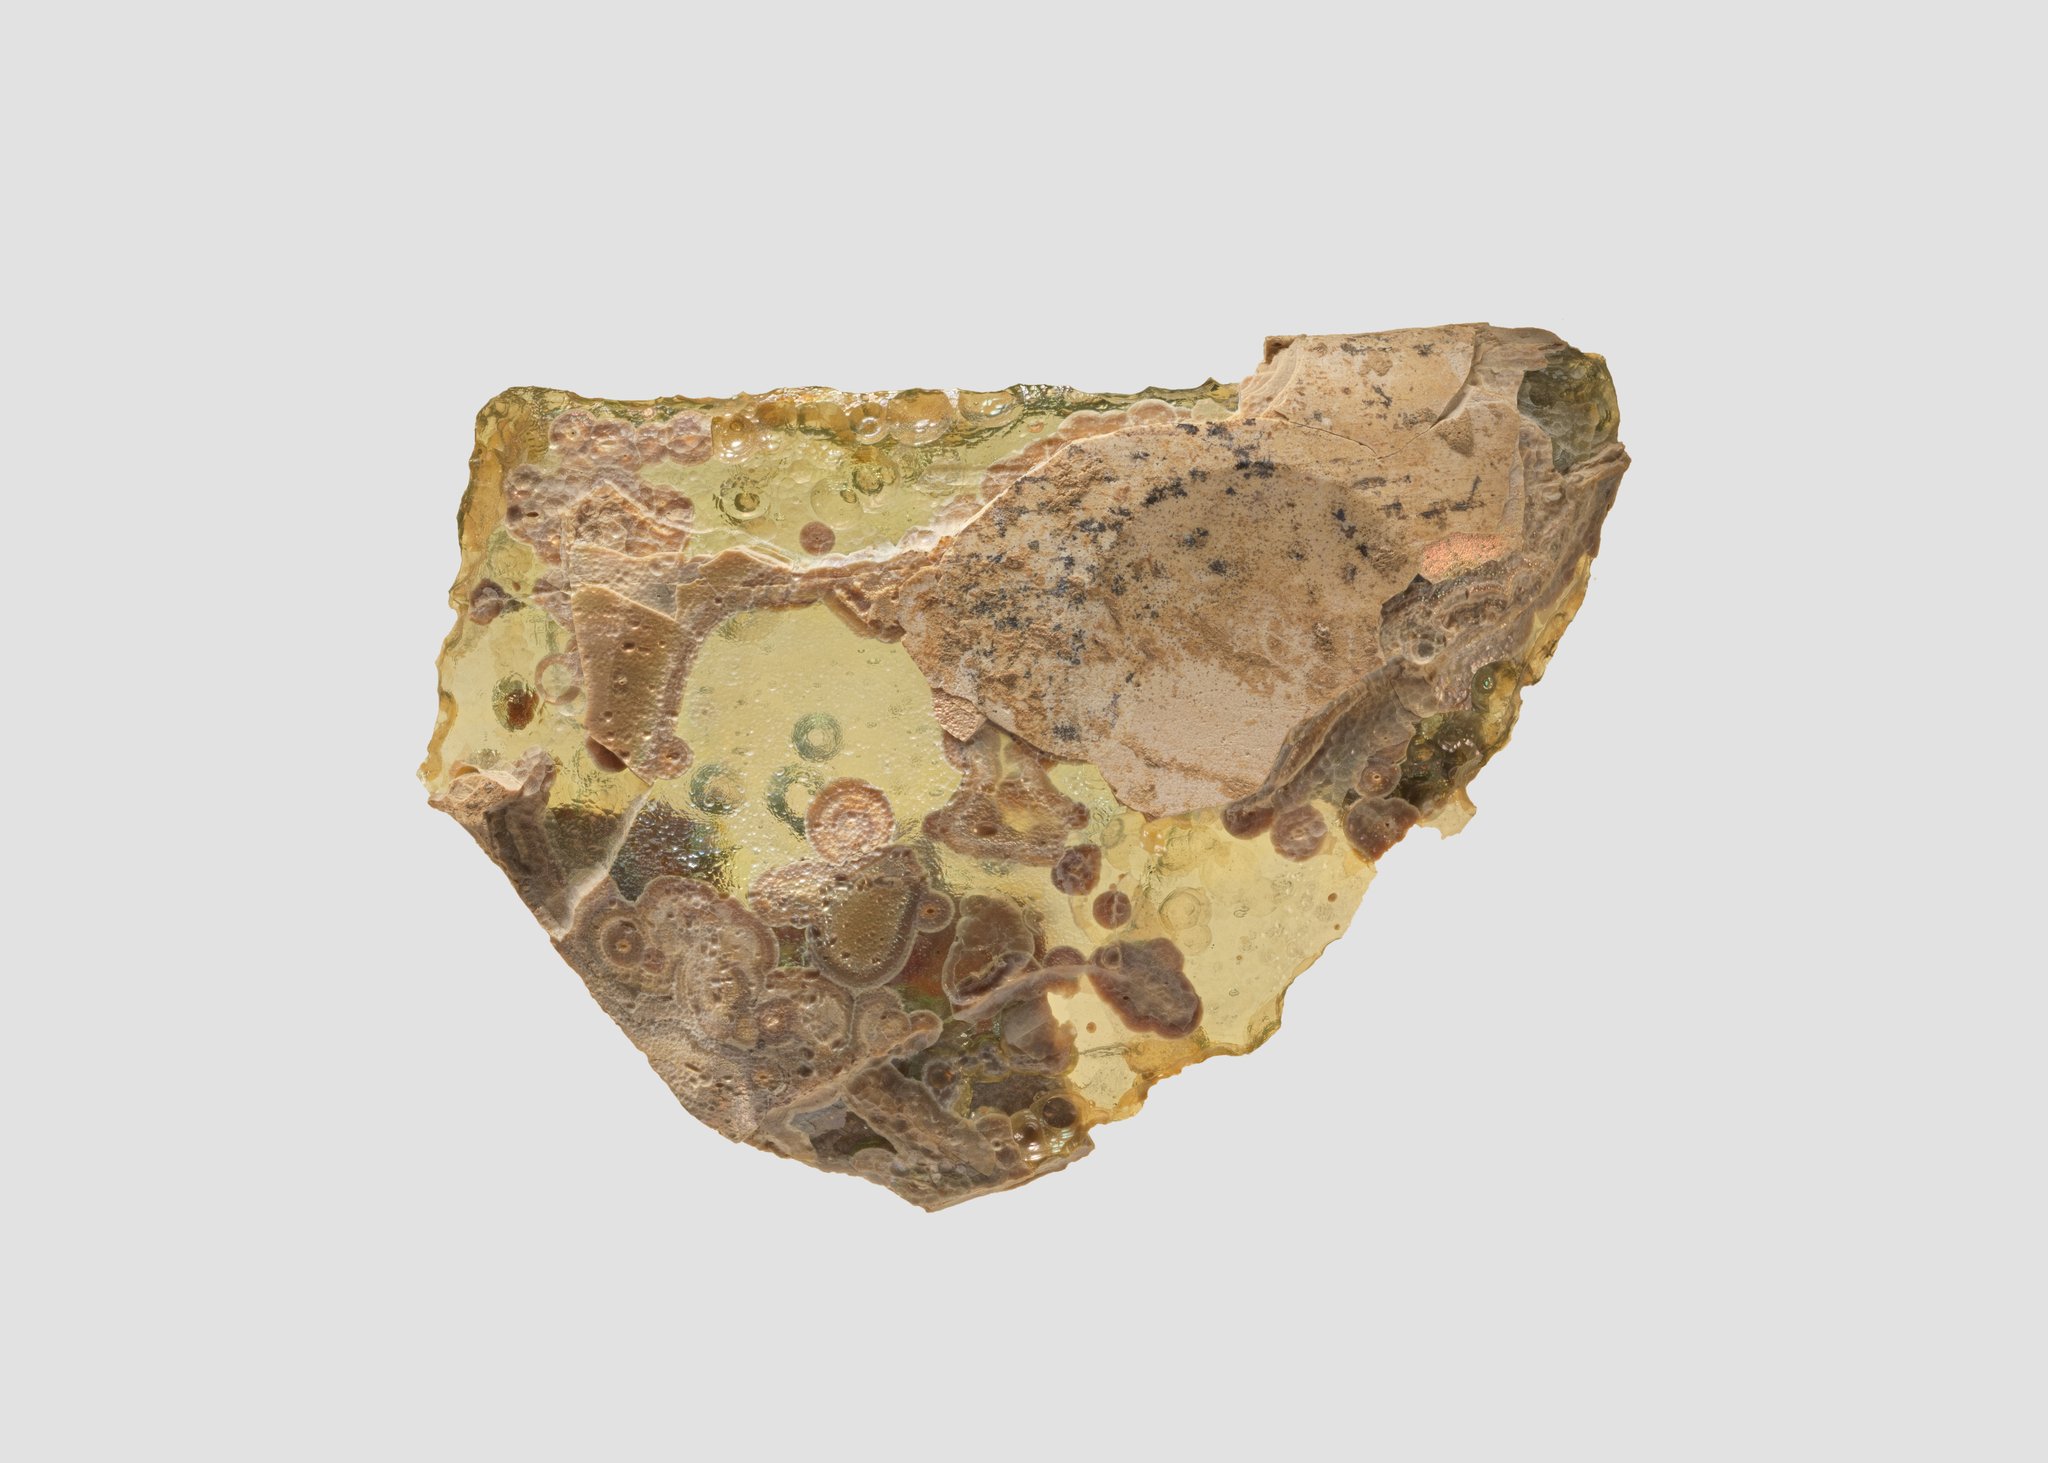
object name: bowl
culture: sasanian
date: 201-700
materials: glass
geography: mesopotamia